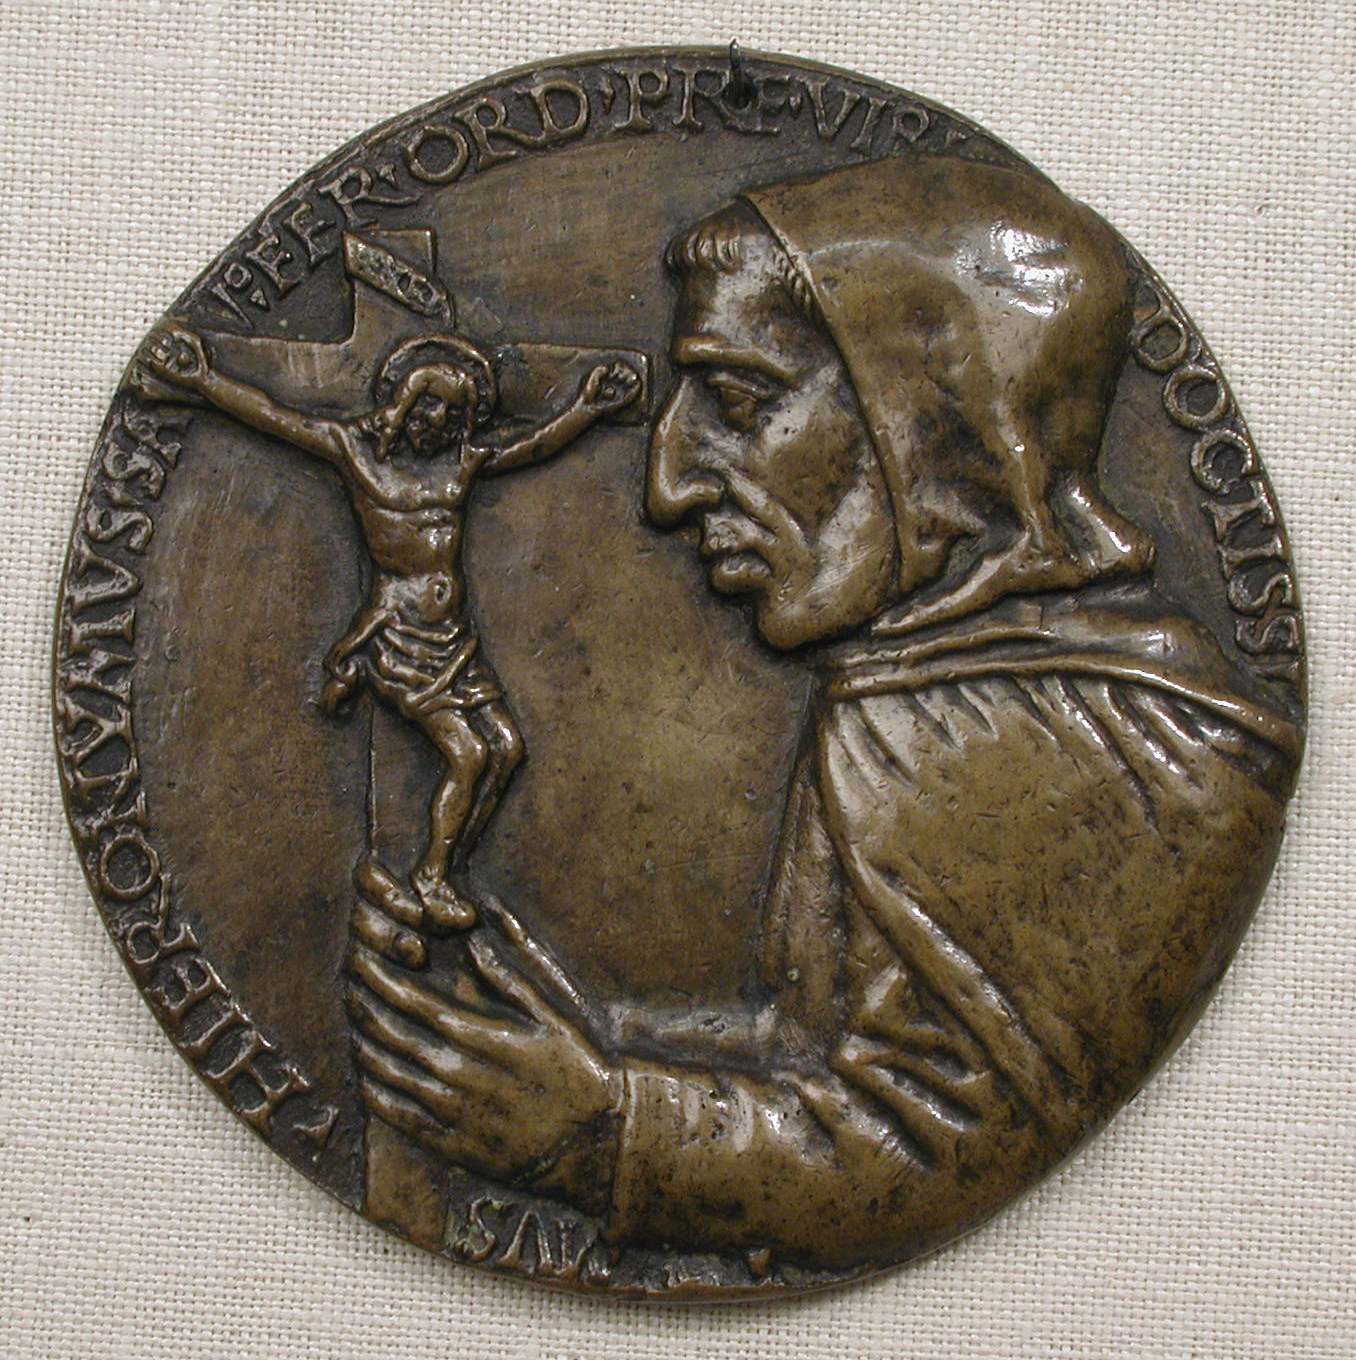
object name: medal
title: Girolamo Savonarola (1452–1498)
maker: niccolò fiorentino (niccolò di forzore spinelli)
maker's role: maker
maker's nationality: italian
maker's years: 1430-1514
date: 1467-1500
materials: bronze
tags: profiles,cross,monks,crucifixion